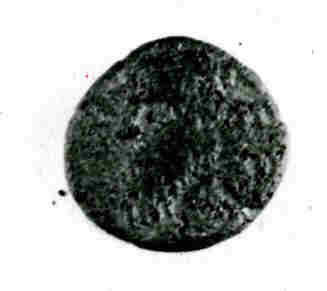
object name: coin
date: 201-300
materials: copper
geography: iran